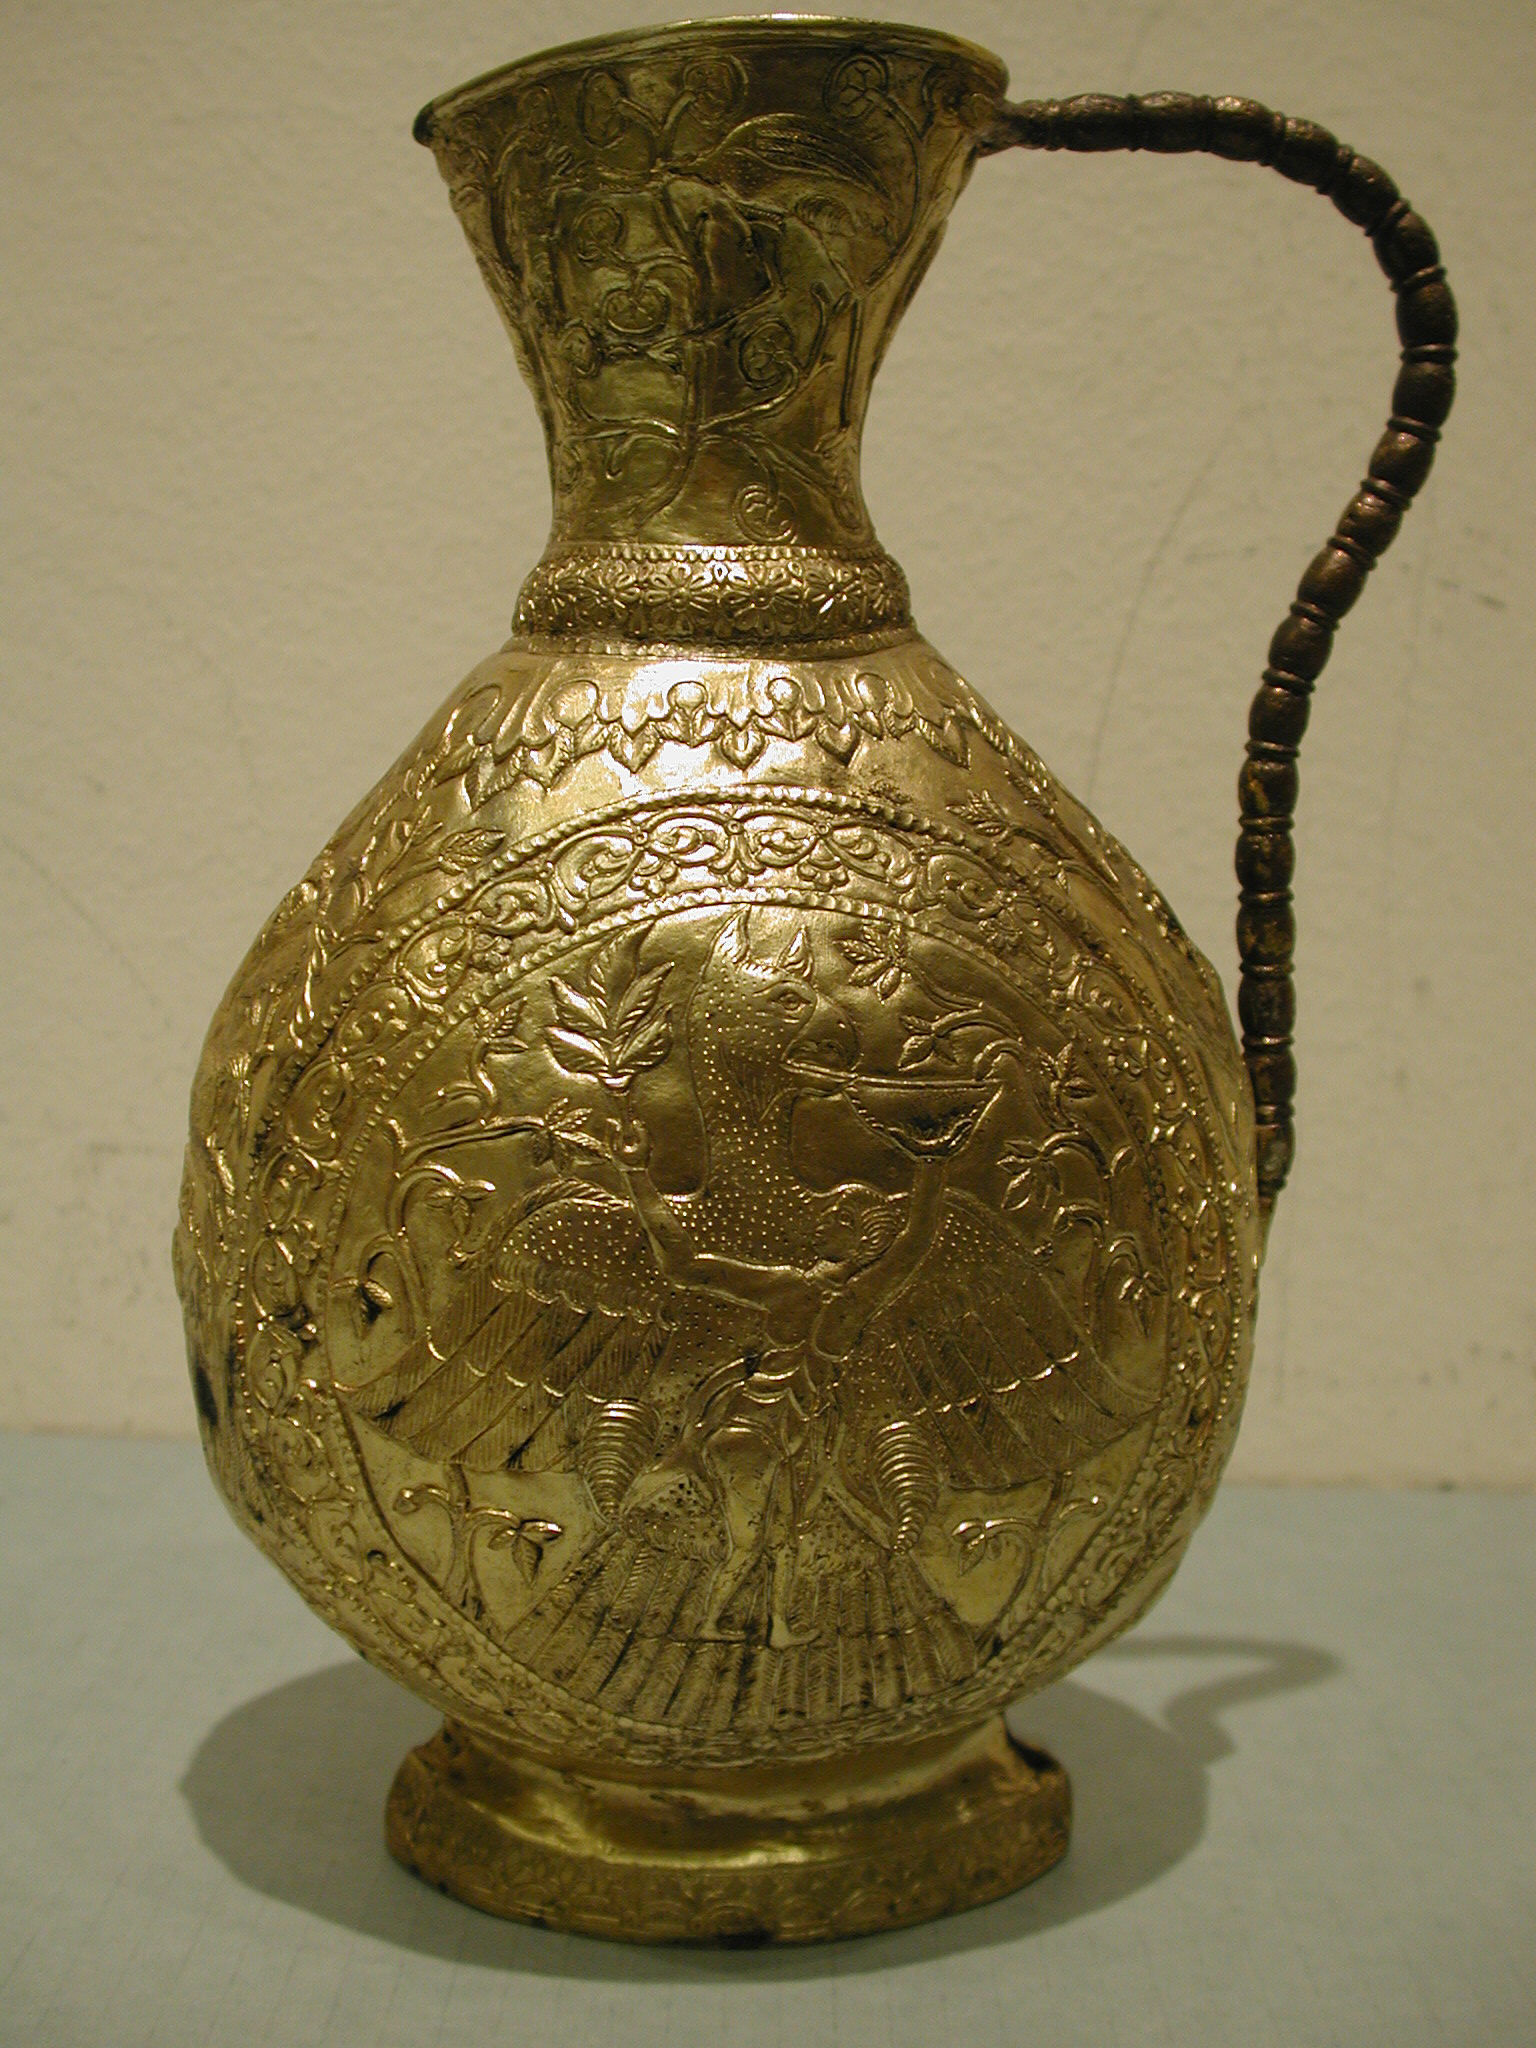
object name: ewer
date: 1801-1900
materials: metal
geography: hungary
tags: men,mythical creatures